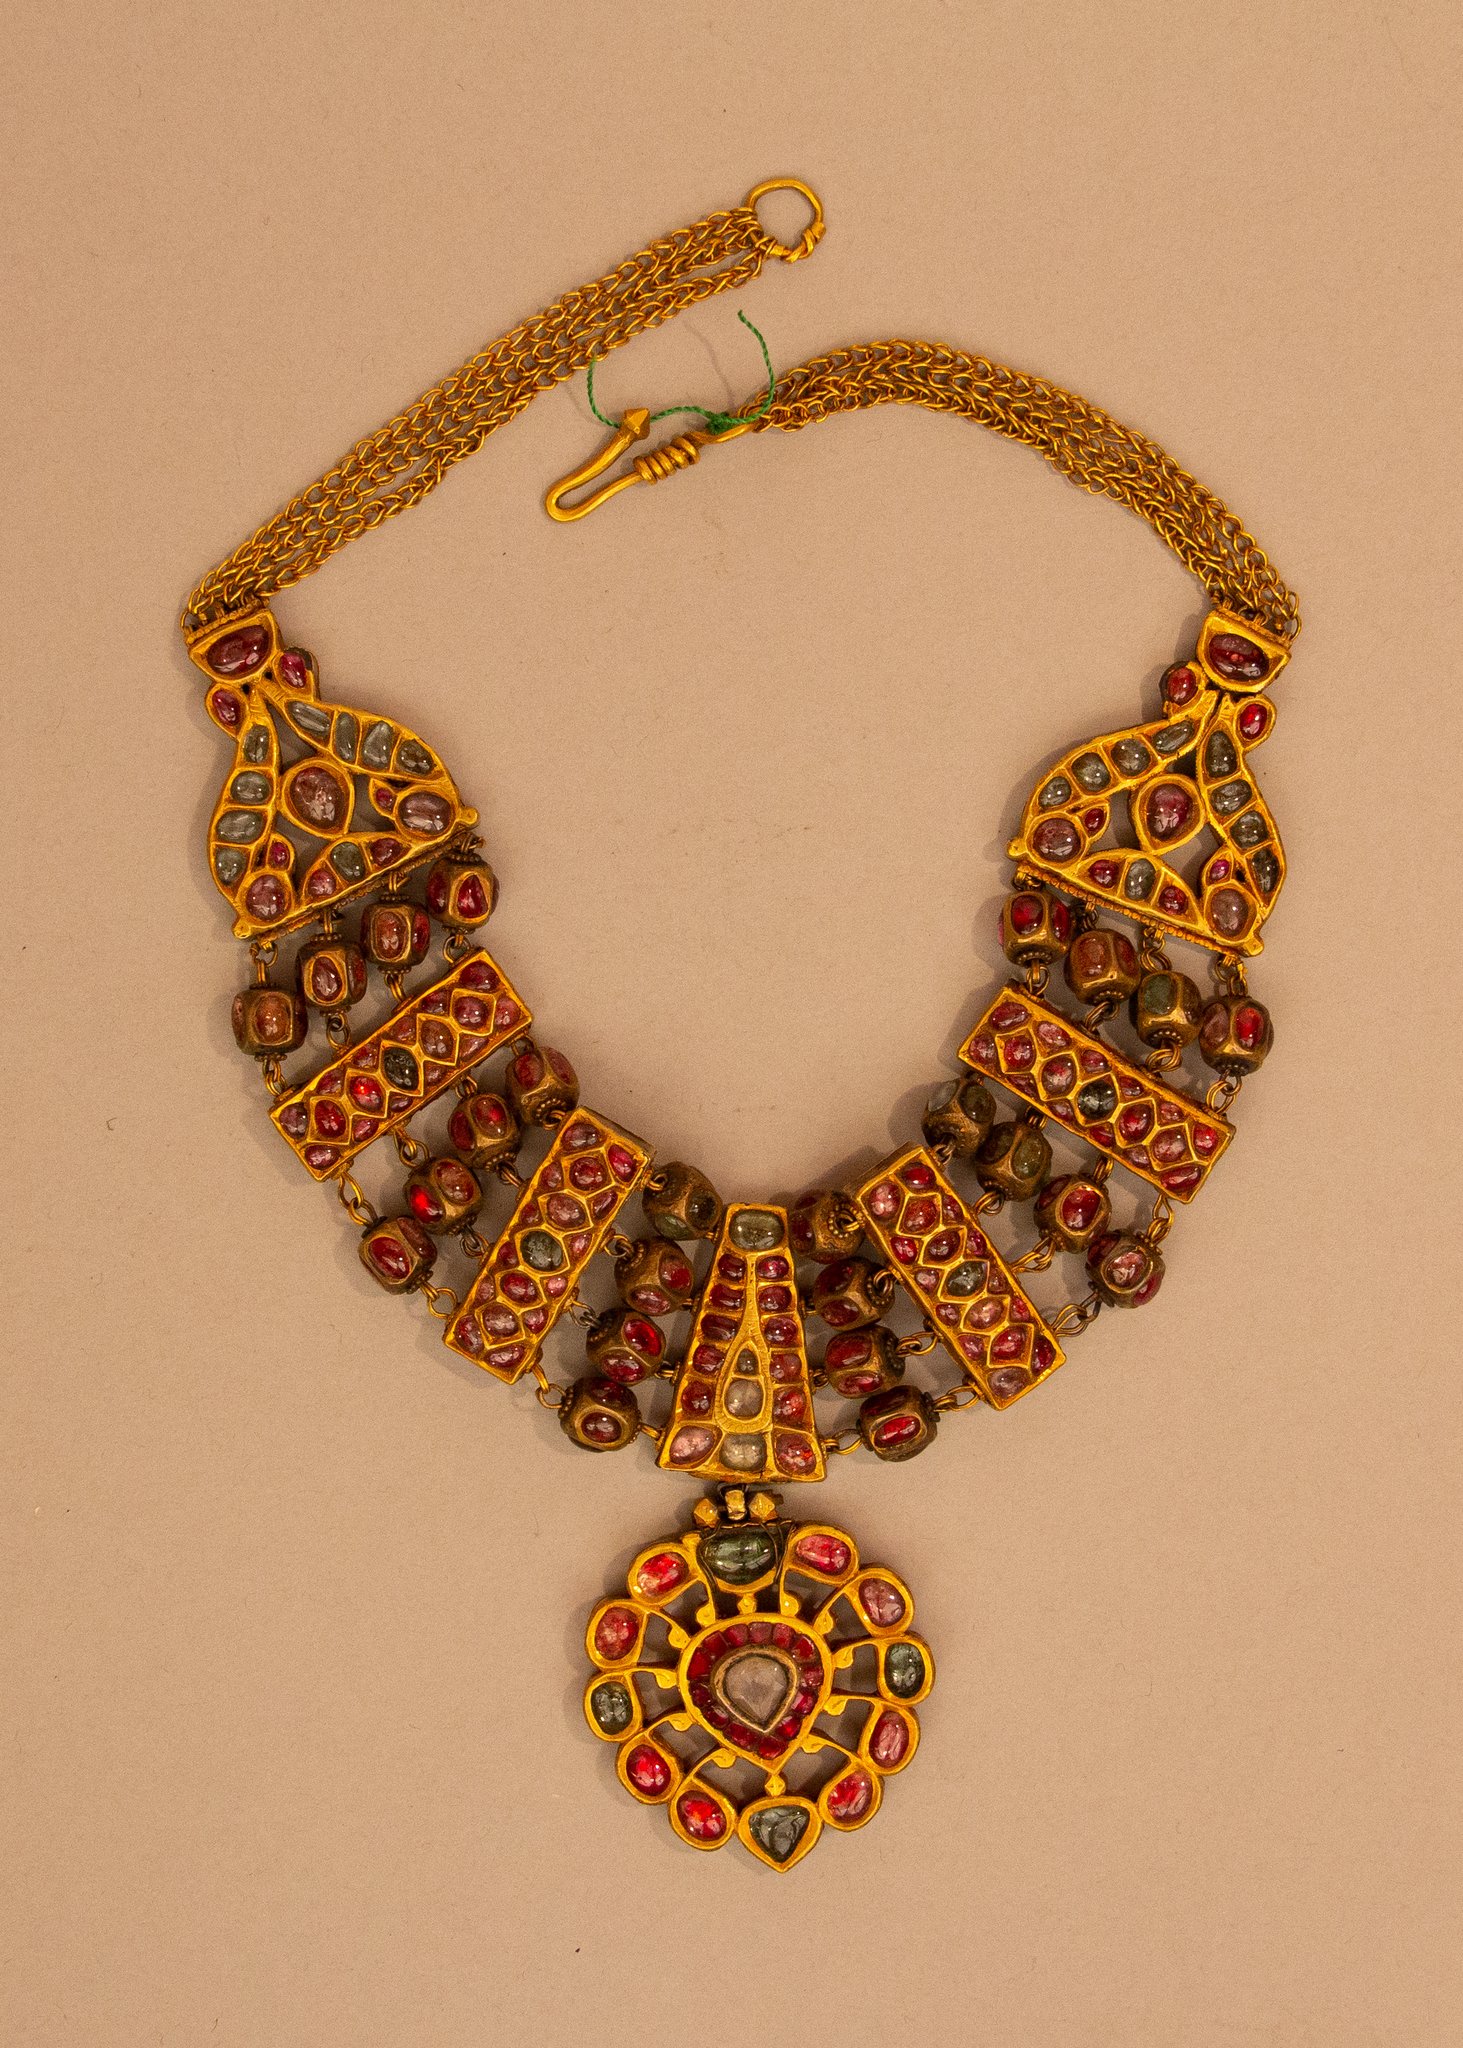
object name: necklace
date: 1701-1900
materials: gold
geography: northern india